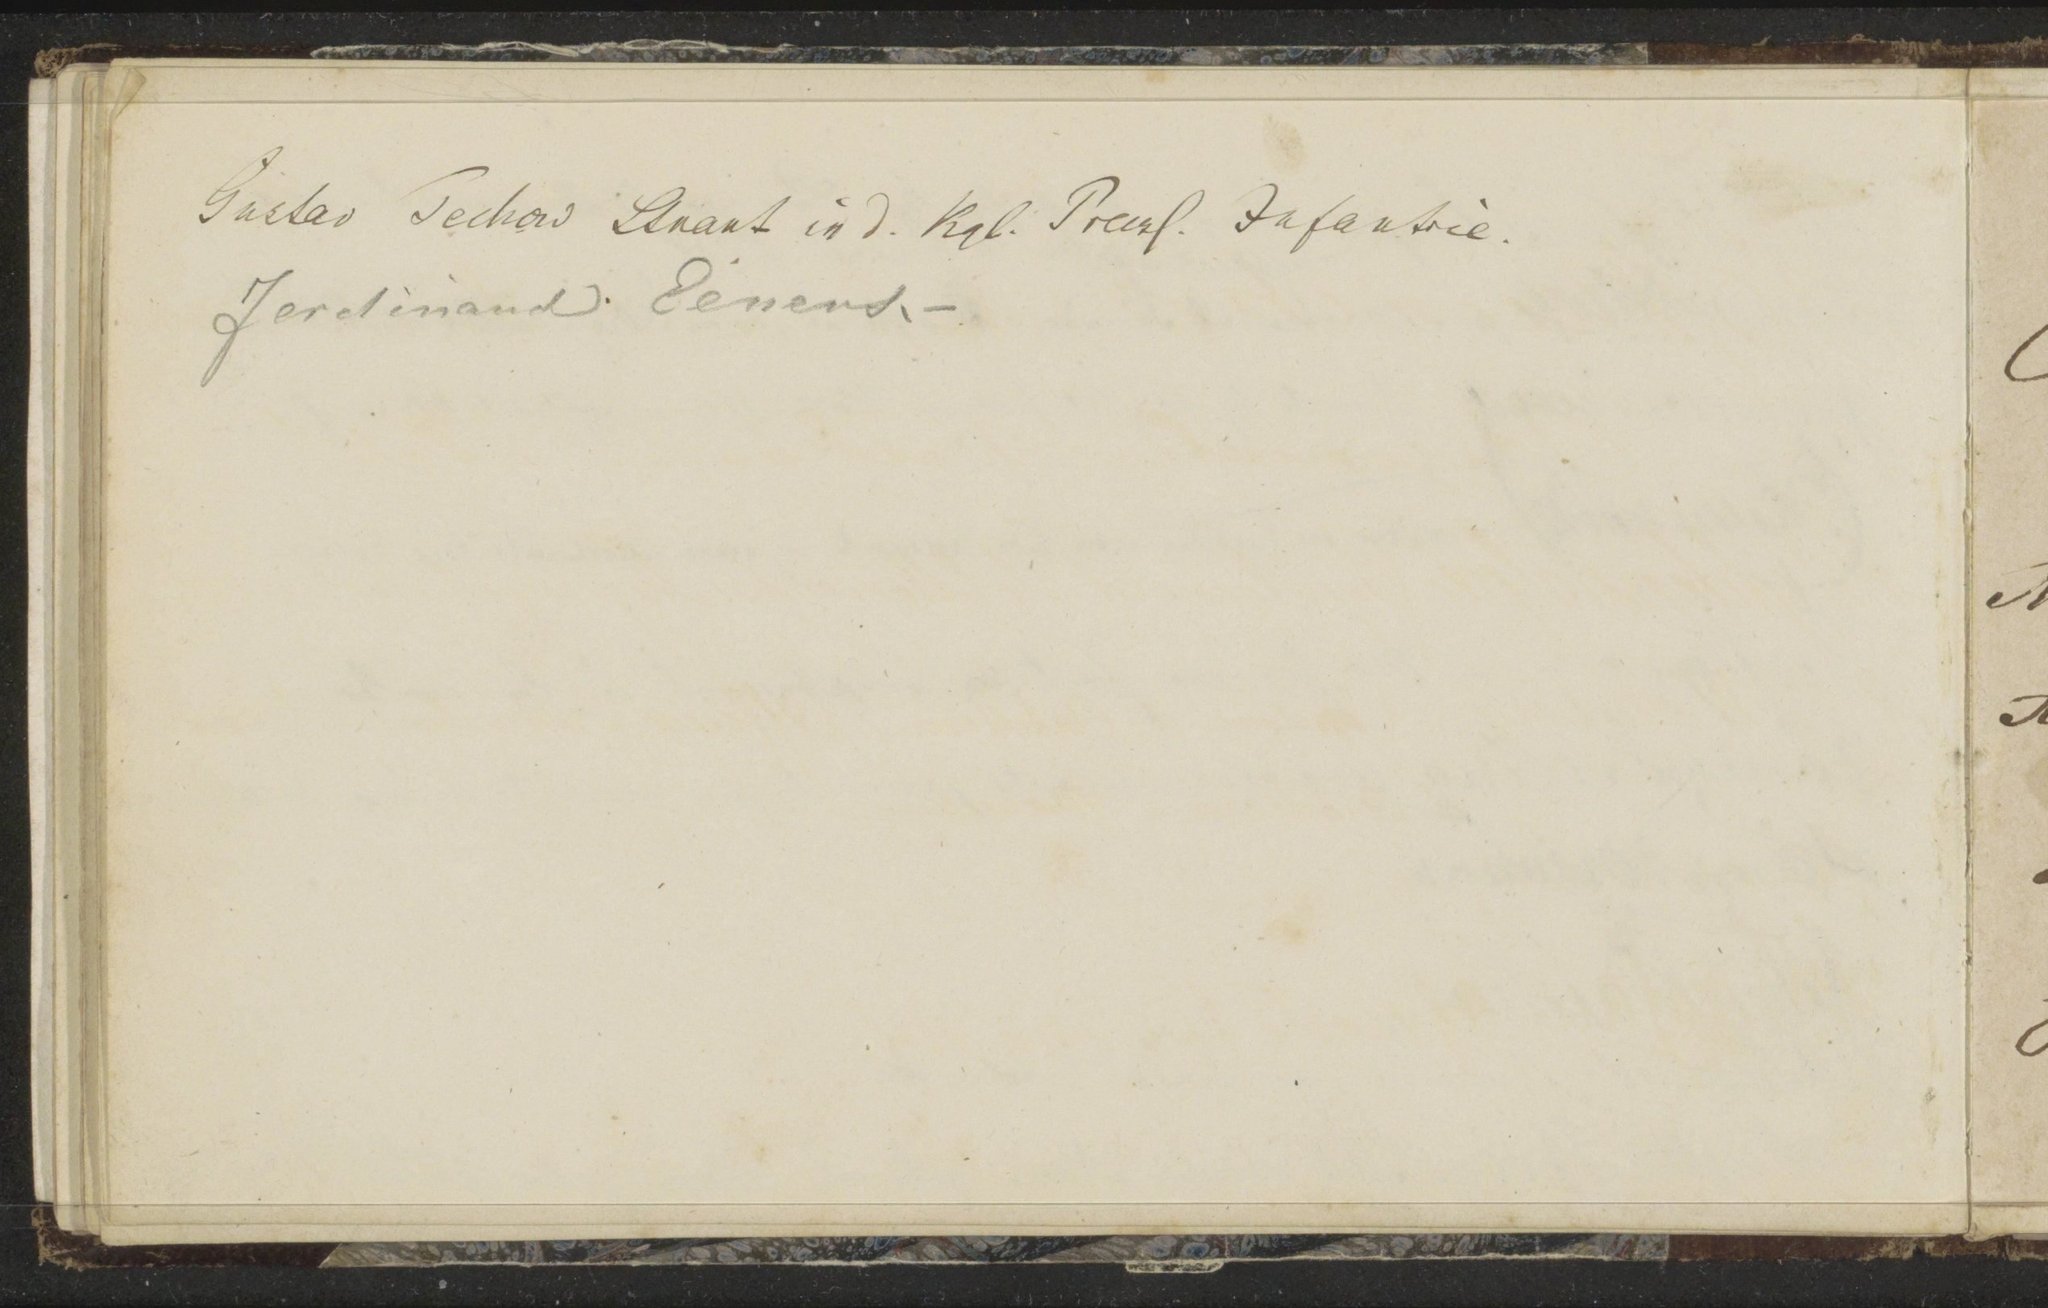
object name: sketchbook leaf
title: Namen van Zweedse militairen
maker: christian heinrich gottlieb steuerwald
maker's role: draughtsman, print maker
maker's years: 1802-1874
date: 1845-1848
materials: ink, paper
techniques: pen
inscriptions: annotation: ‘Gaskav? ... Eenens.-’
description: Blad 17 verso uit een schetsboek met 61 bladen.